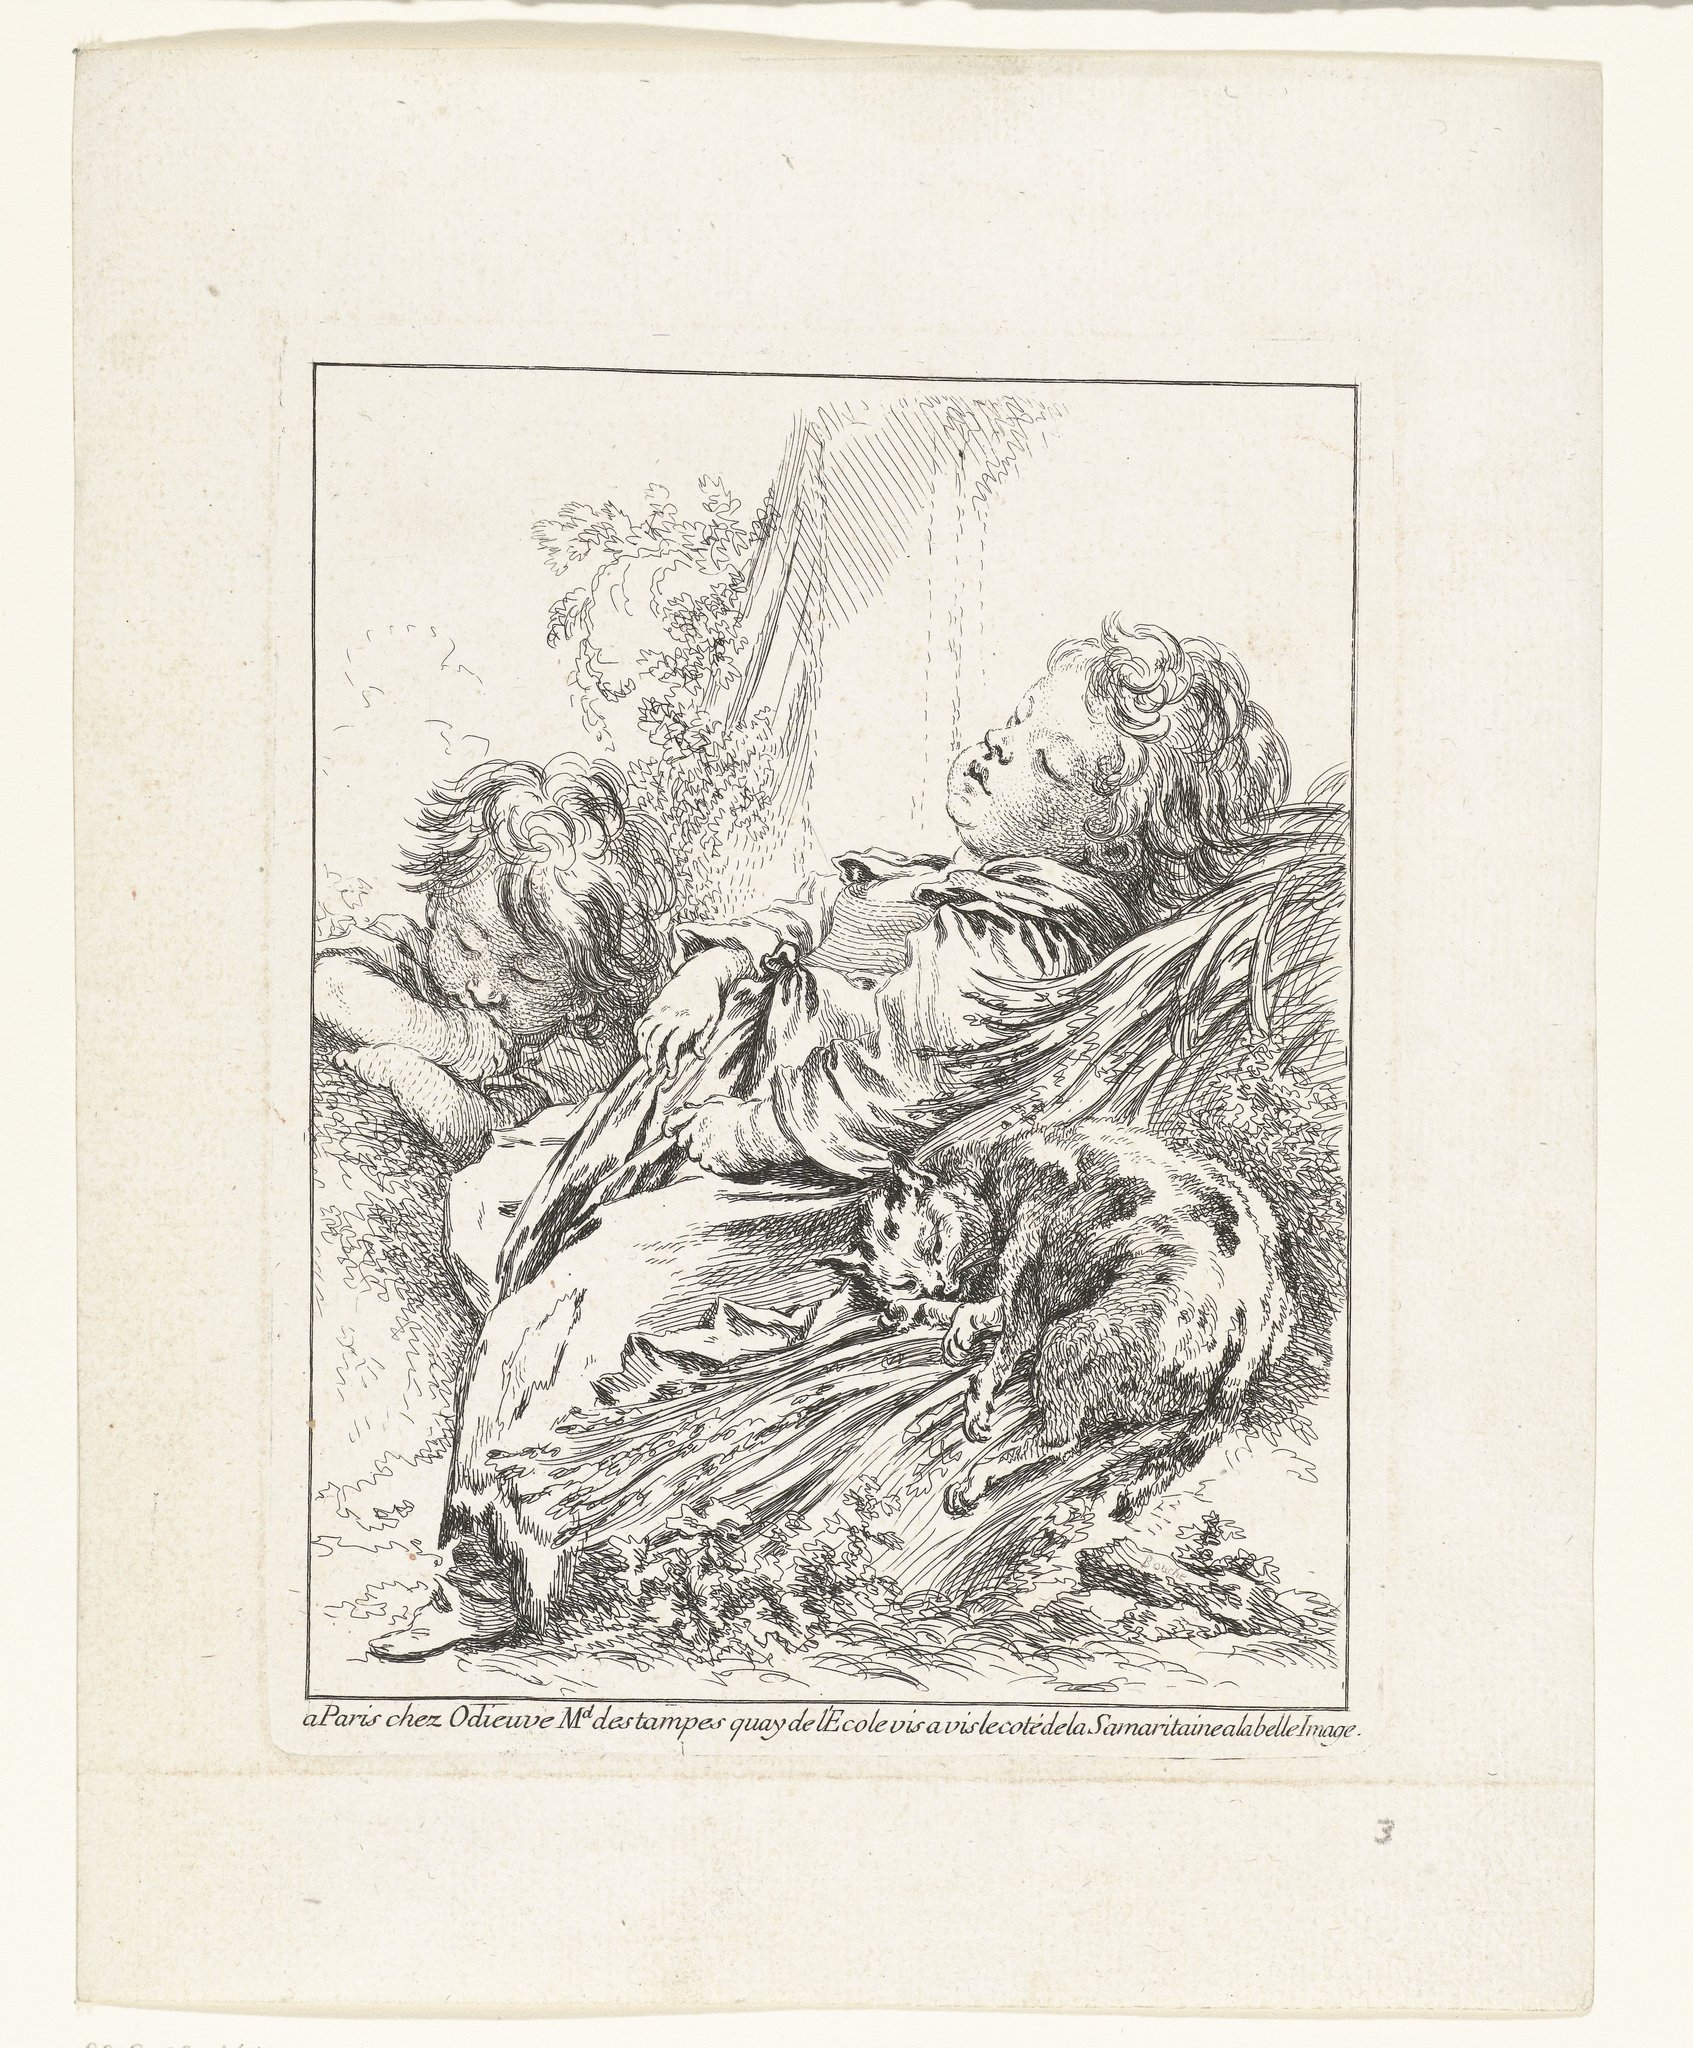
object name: print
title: Le sommeil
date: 1730-1740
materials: paper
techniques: etching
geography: paris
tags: cat, sleeping on the ground, animals (+ sleeping animal(s)), child (+ two persons)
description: De tekening voor deze prent bevindt zich in het Museum van Stockholm.